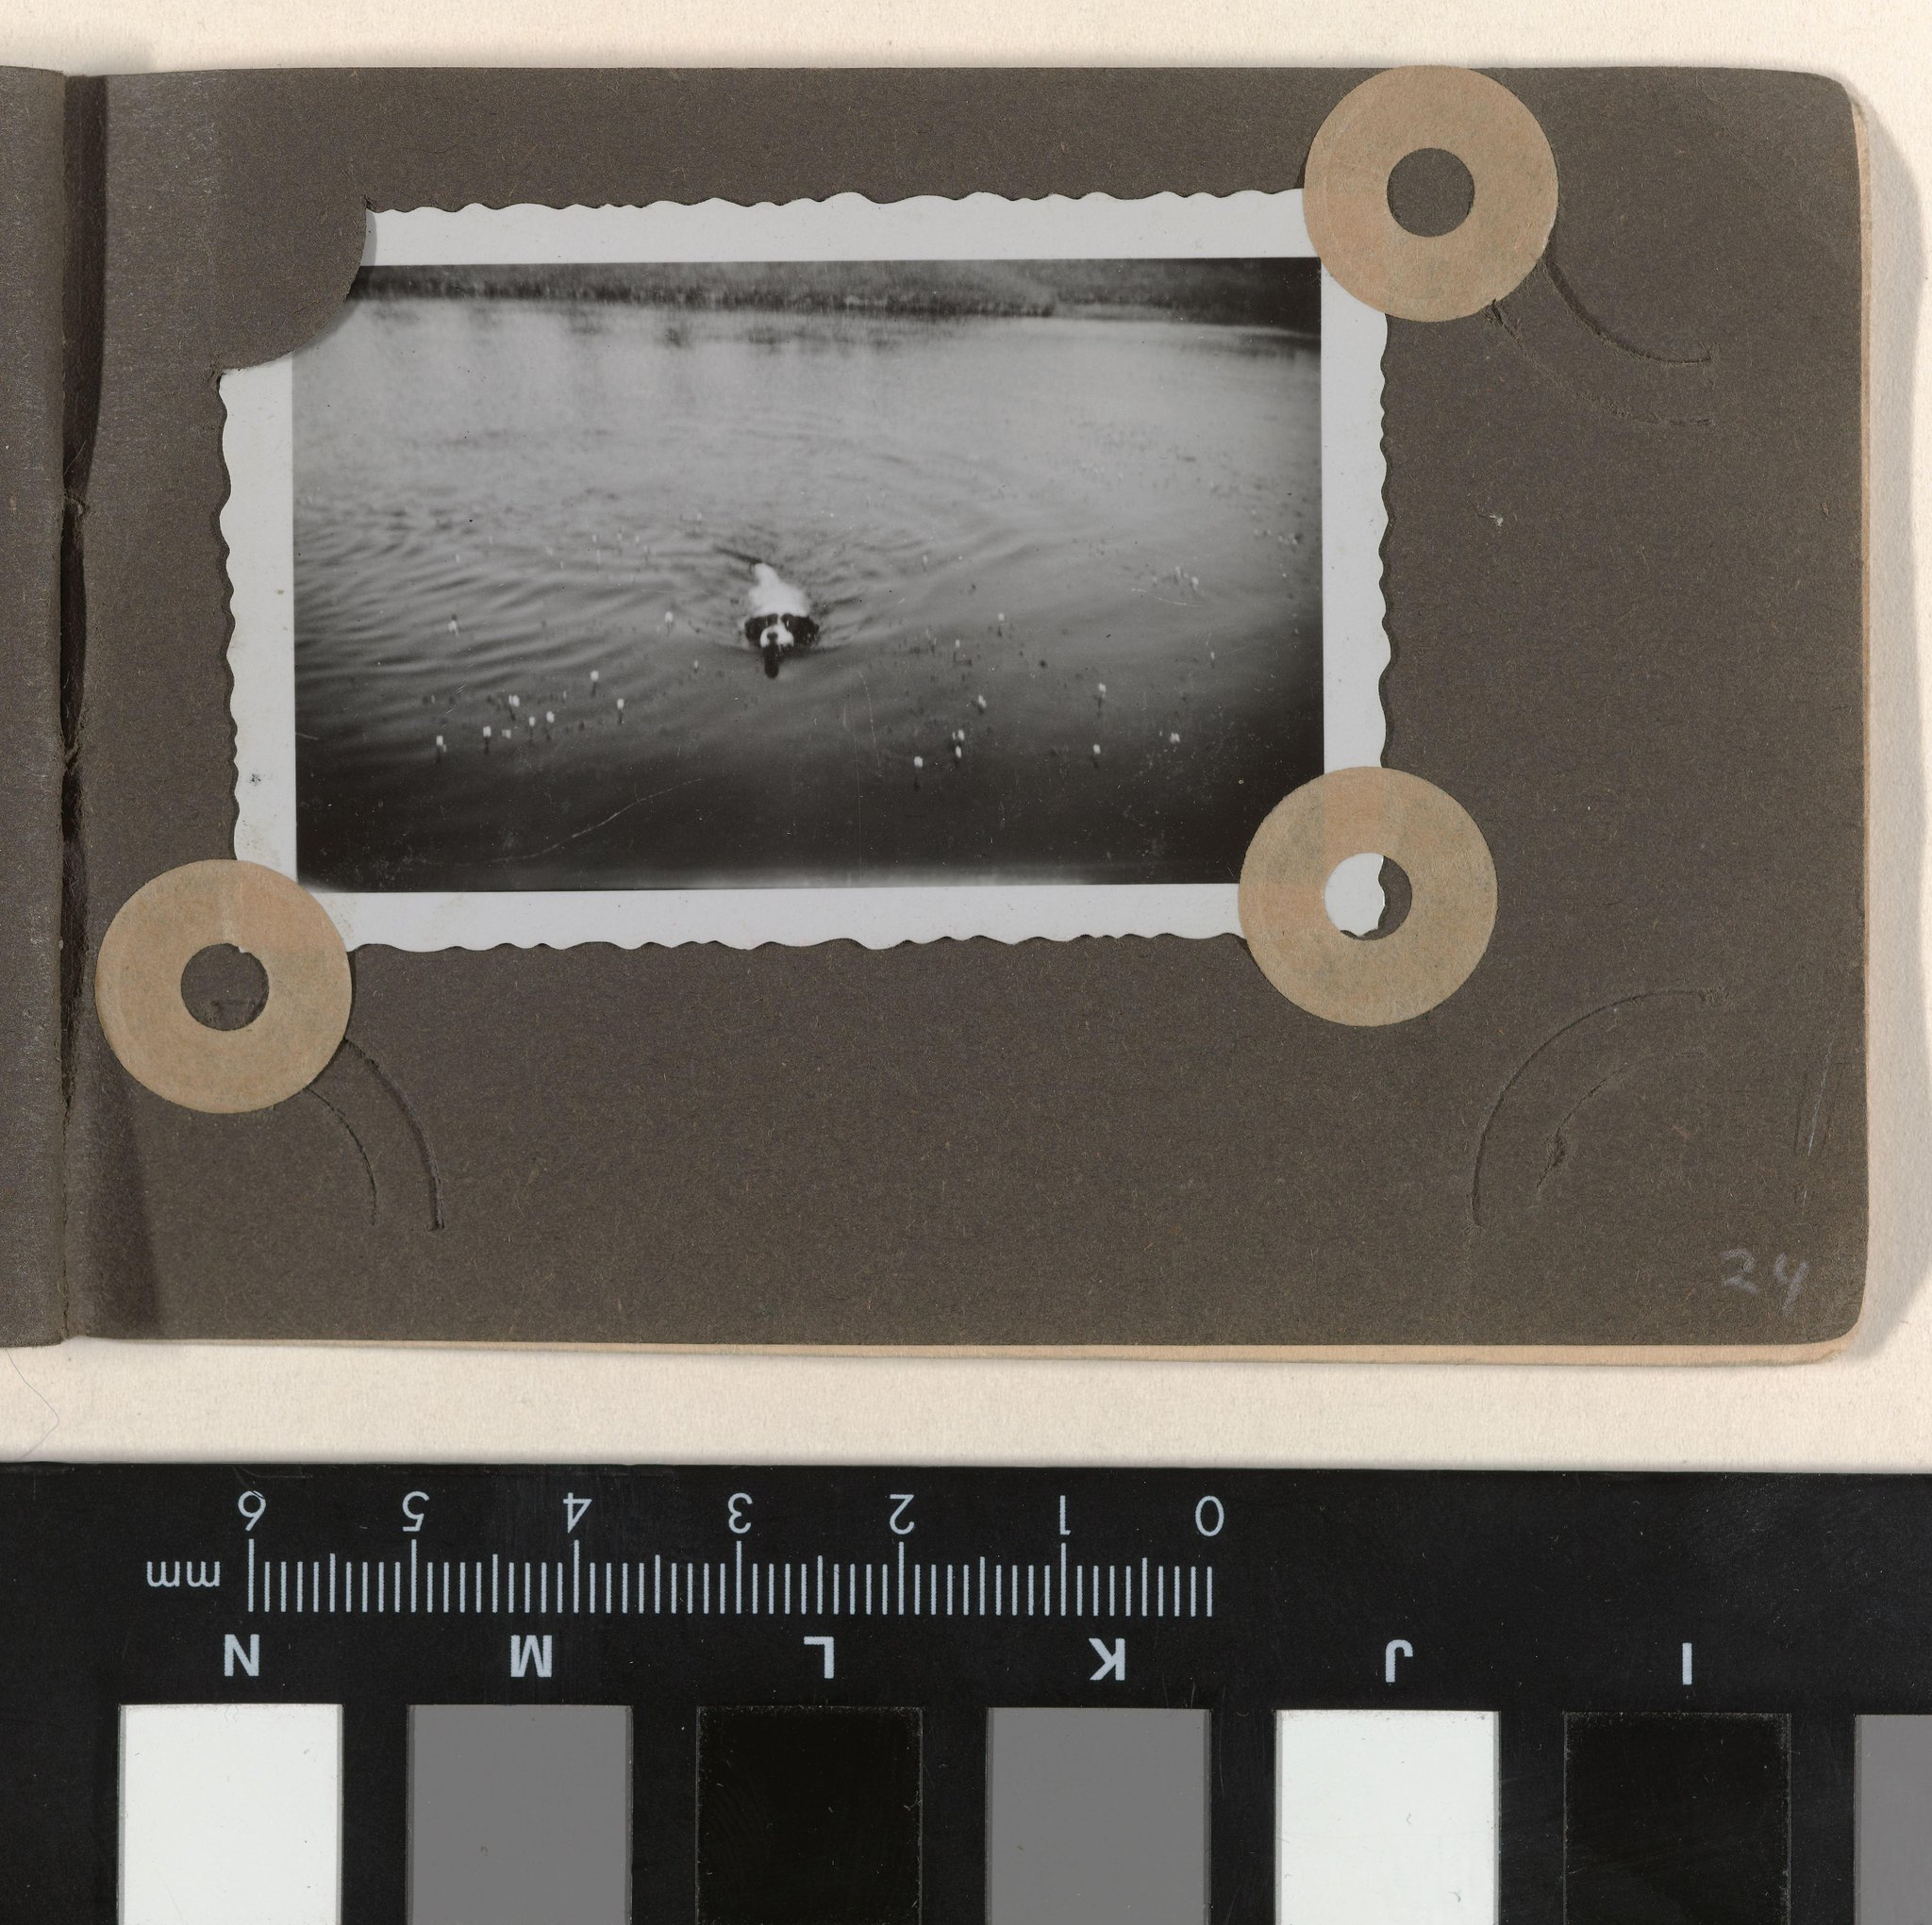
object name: photograph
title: Hond in water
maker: Anonymous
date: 1933-1944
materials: photographic support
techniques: gelatin silver print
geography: rotterdam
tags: wim van den bosch, netherlands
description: Een hond zwemmend in het water. Onderdeel van het familiealbum 1933-1944.